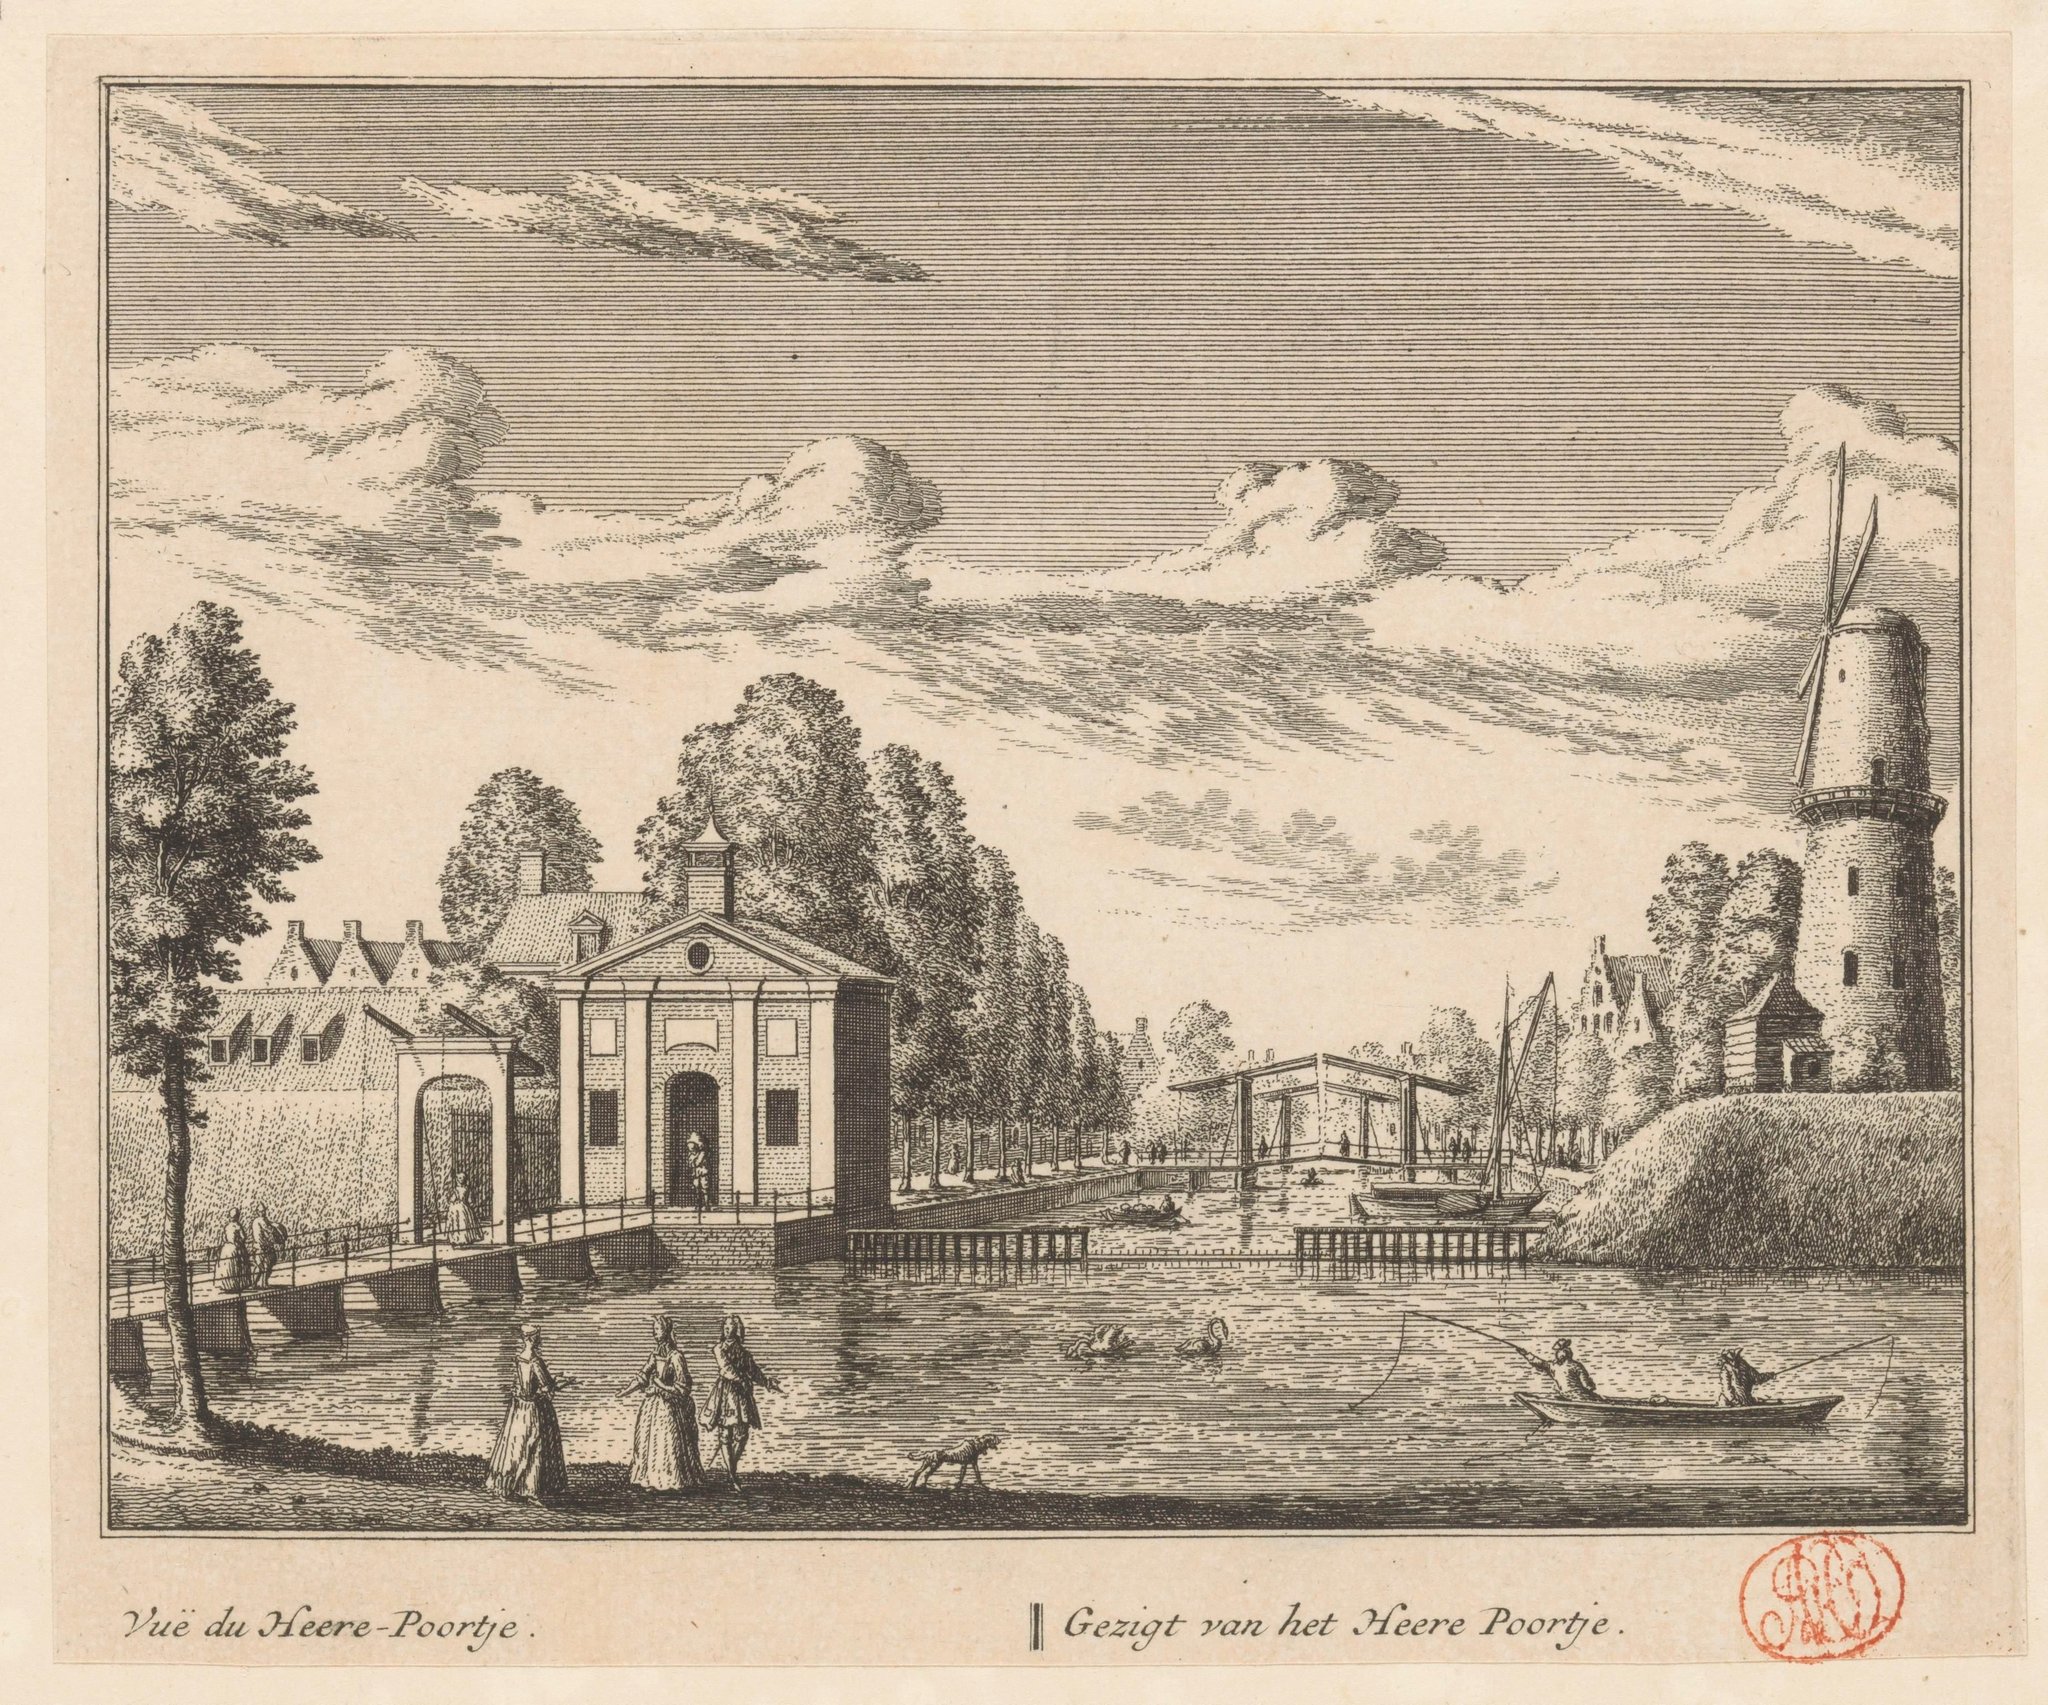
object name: book illustration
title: Gezicht op de Herenpoort te Leiden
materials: paper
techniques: etching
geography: amsterdam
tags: bridge, windmill, city-gate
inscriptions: collector's mark: Lugt 2228, collector's mark: Lugt 195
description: Prent ook gebruikt in: Rademaker, Abraham. Rhynlands fraaiste gezichten; vertonende alle deszelfs lustplaatzen, heeren-huizen en dorpen. Van halfwegen Haarlem en Leyden (…) / Les plus agréables vuës de Rhynland, representant toutes les maisons de plaisance, maisons seigneuriales & villages. Commençant à demilieu Haarlem & Leyden (…). Ansterdam: Leonard Schenk, 1732.